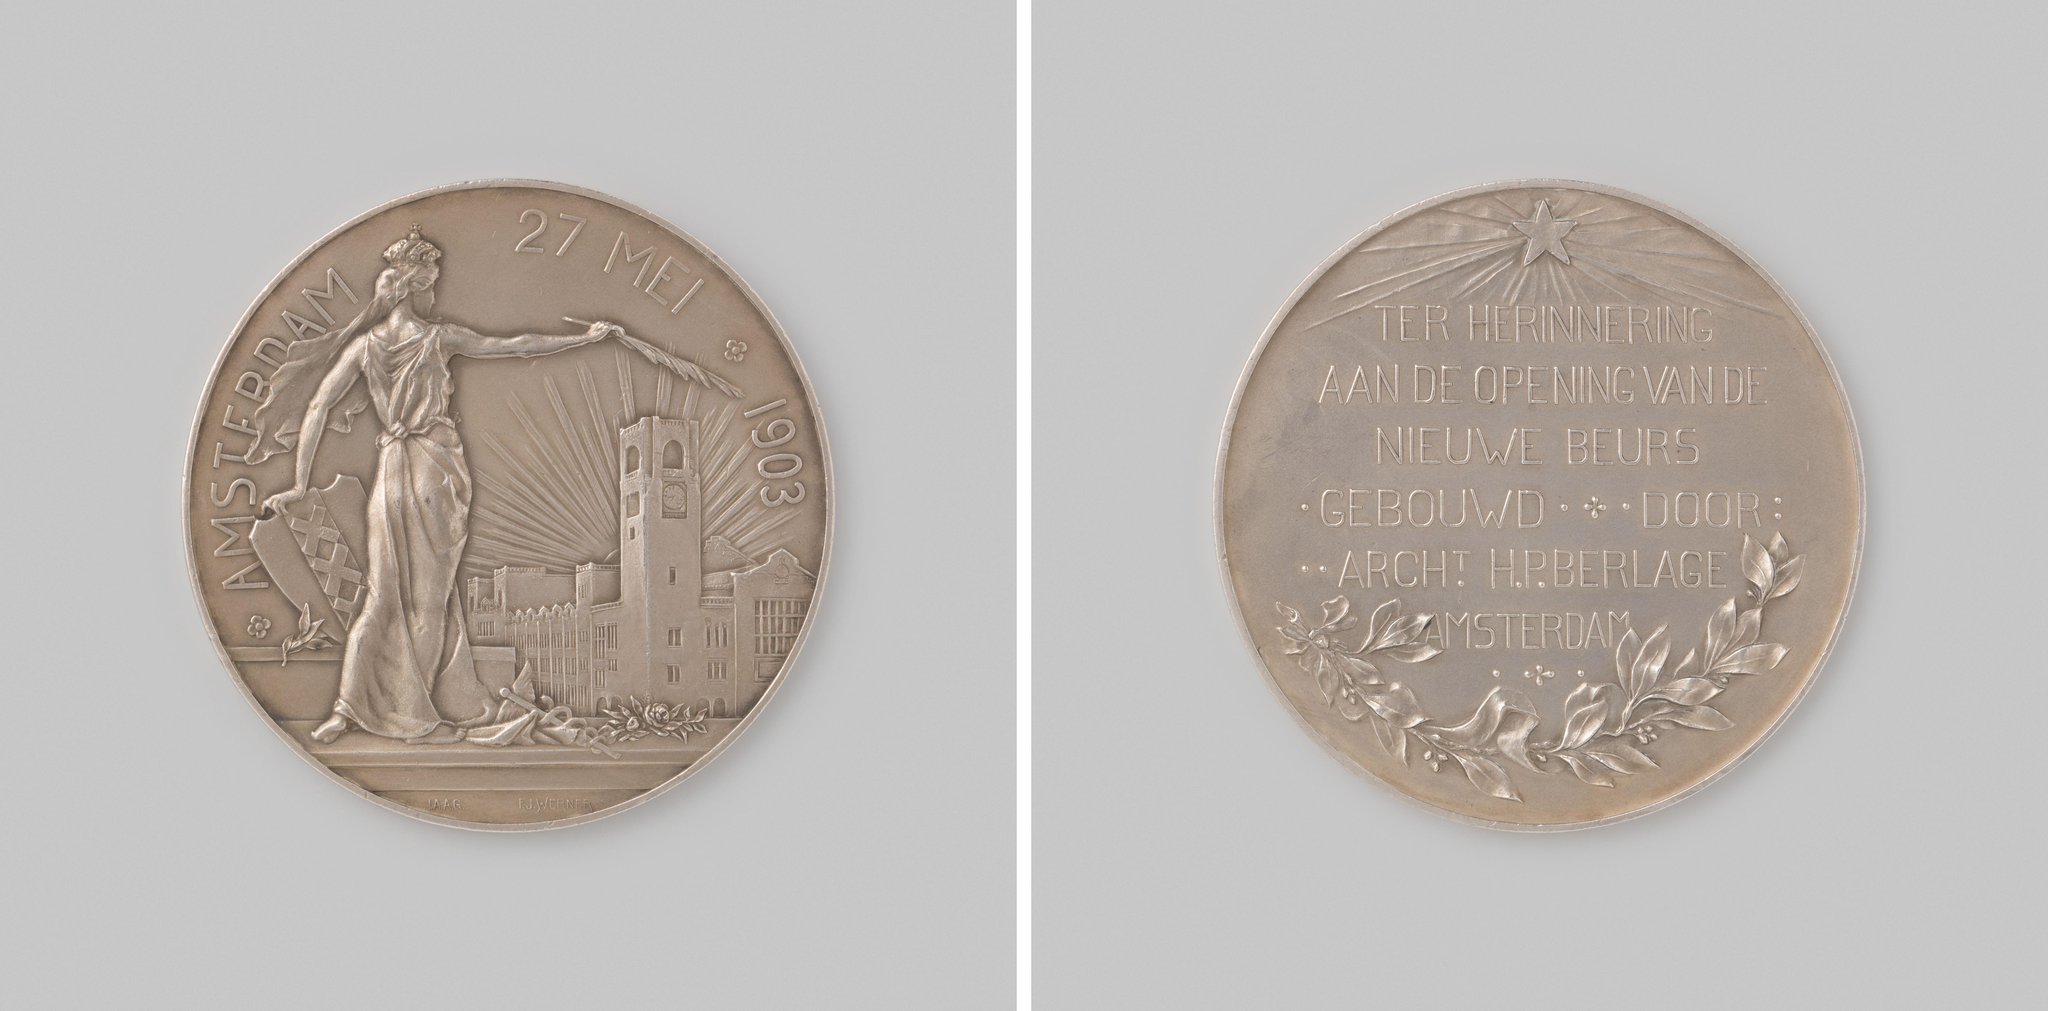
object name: history medal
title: Opening Beurs van Berlage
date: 1903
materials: silver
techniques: striking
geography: amsterdam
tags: personification of a city, town-patron(ess), amsterdam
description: Zilveren penning, voorzijde: vrouw met kroon, op de rug gezien, met in linkerhand op de grond steunend wapenschild van Amsterdam en in rechterhand een olijftak (Amsterdamse stedemaagd), staand op plint waarop enkele voorwerpen als een hermesstaf, met op achtergrond gebouw (de Beurs van Berlage) waarachter zonnestralen, met omschrift. Keerzijde: zesregelige tekst onder stralende ster en boven lauwertak.